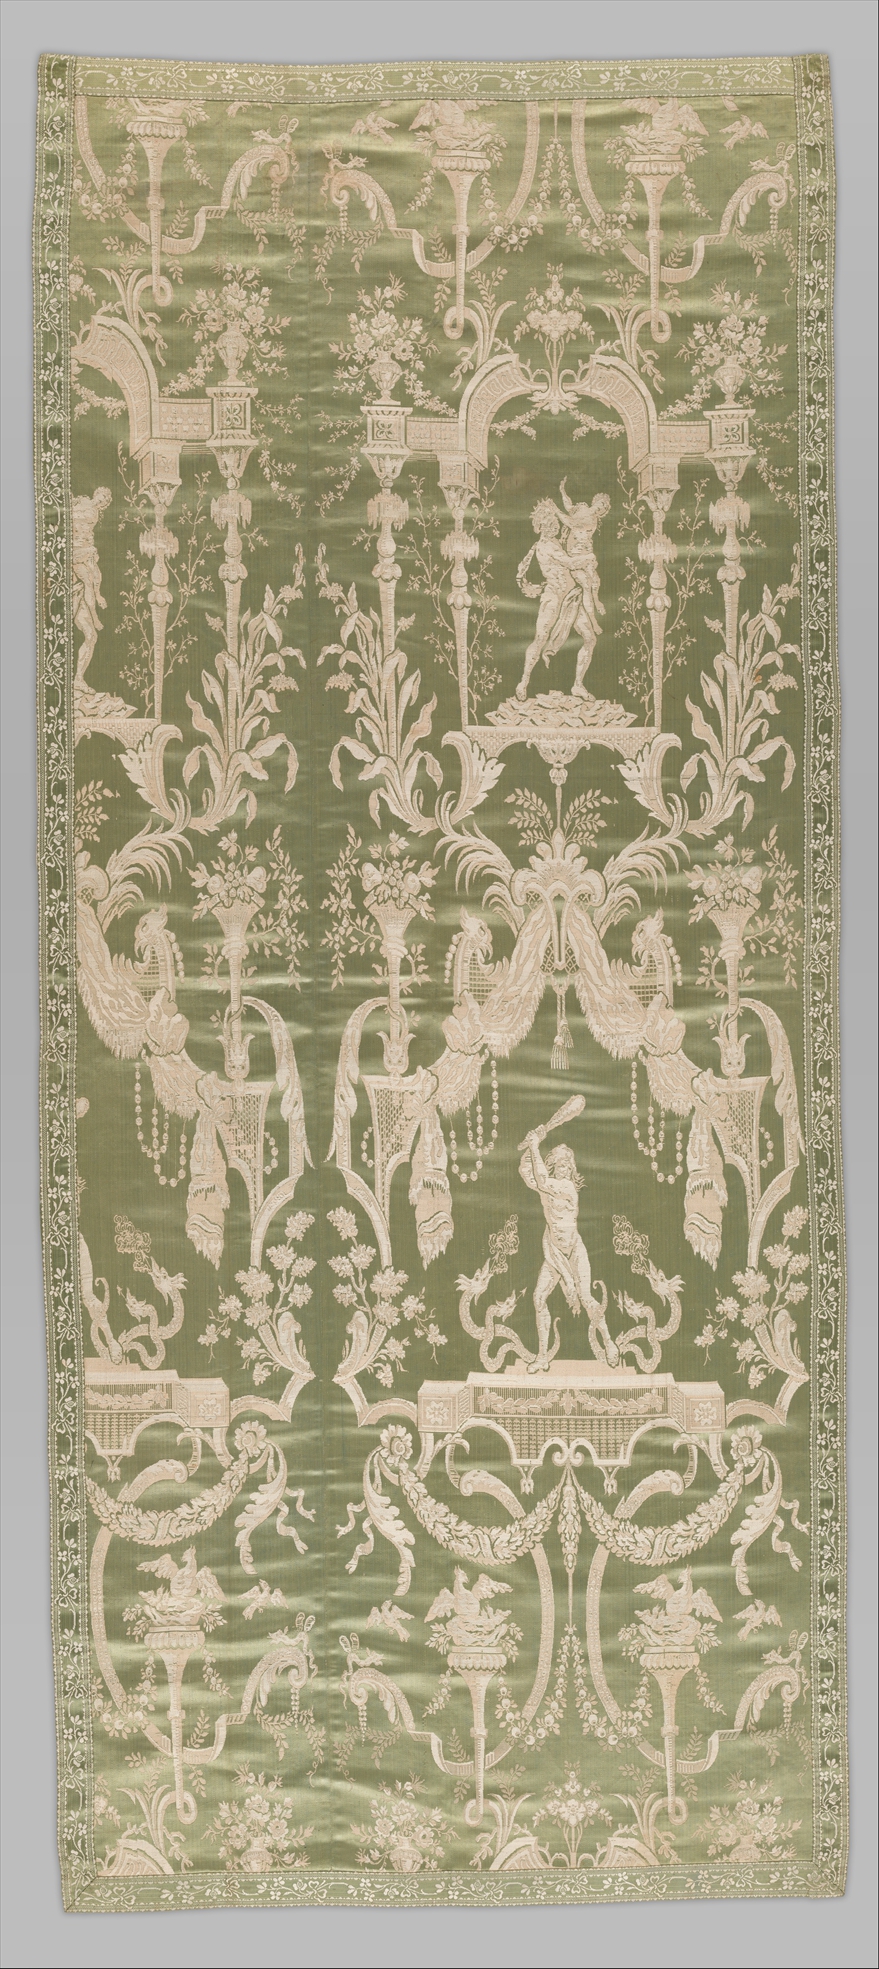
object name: panel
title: Panel with mythological scenes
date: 1790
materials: silk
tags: birds,hercules,serpents,flowers